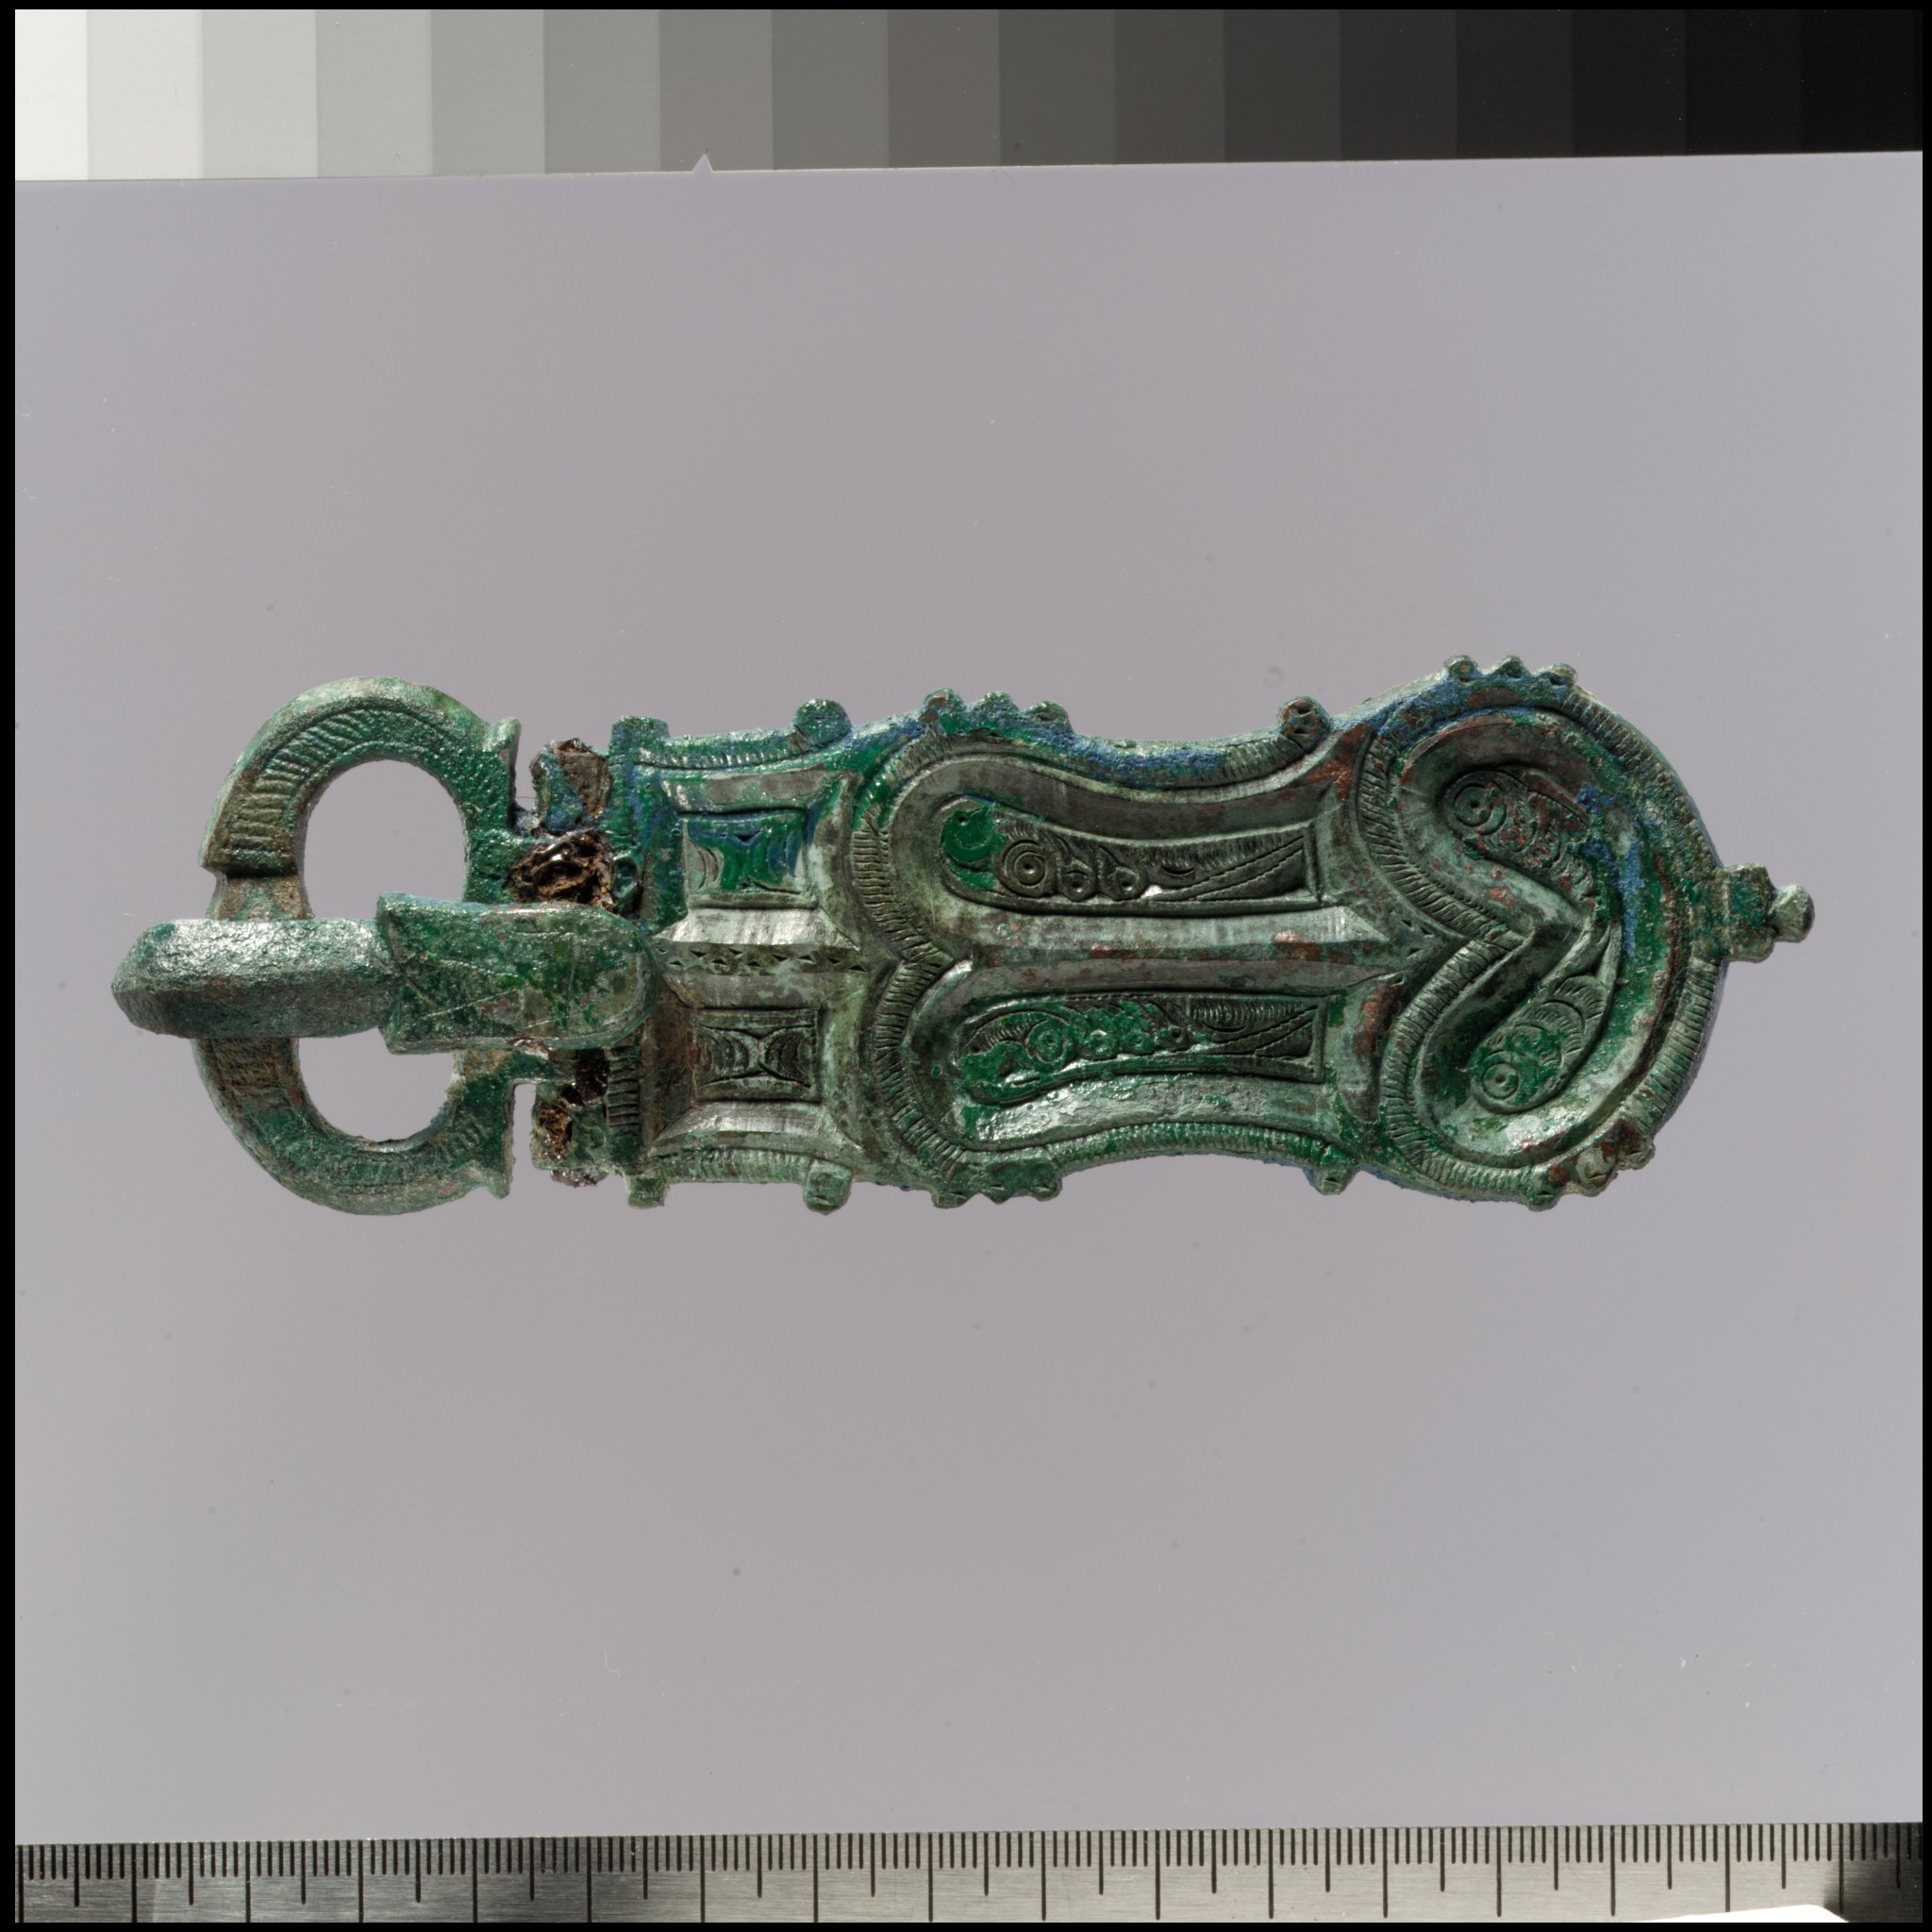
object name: buckle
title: Lyre-Shaped Belt Buckle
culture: hispano-visigothic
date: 600-700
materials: copper alloy